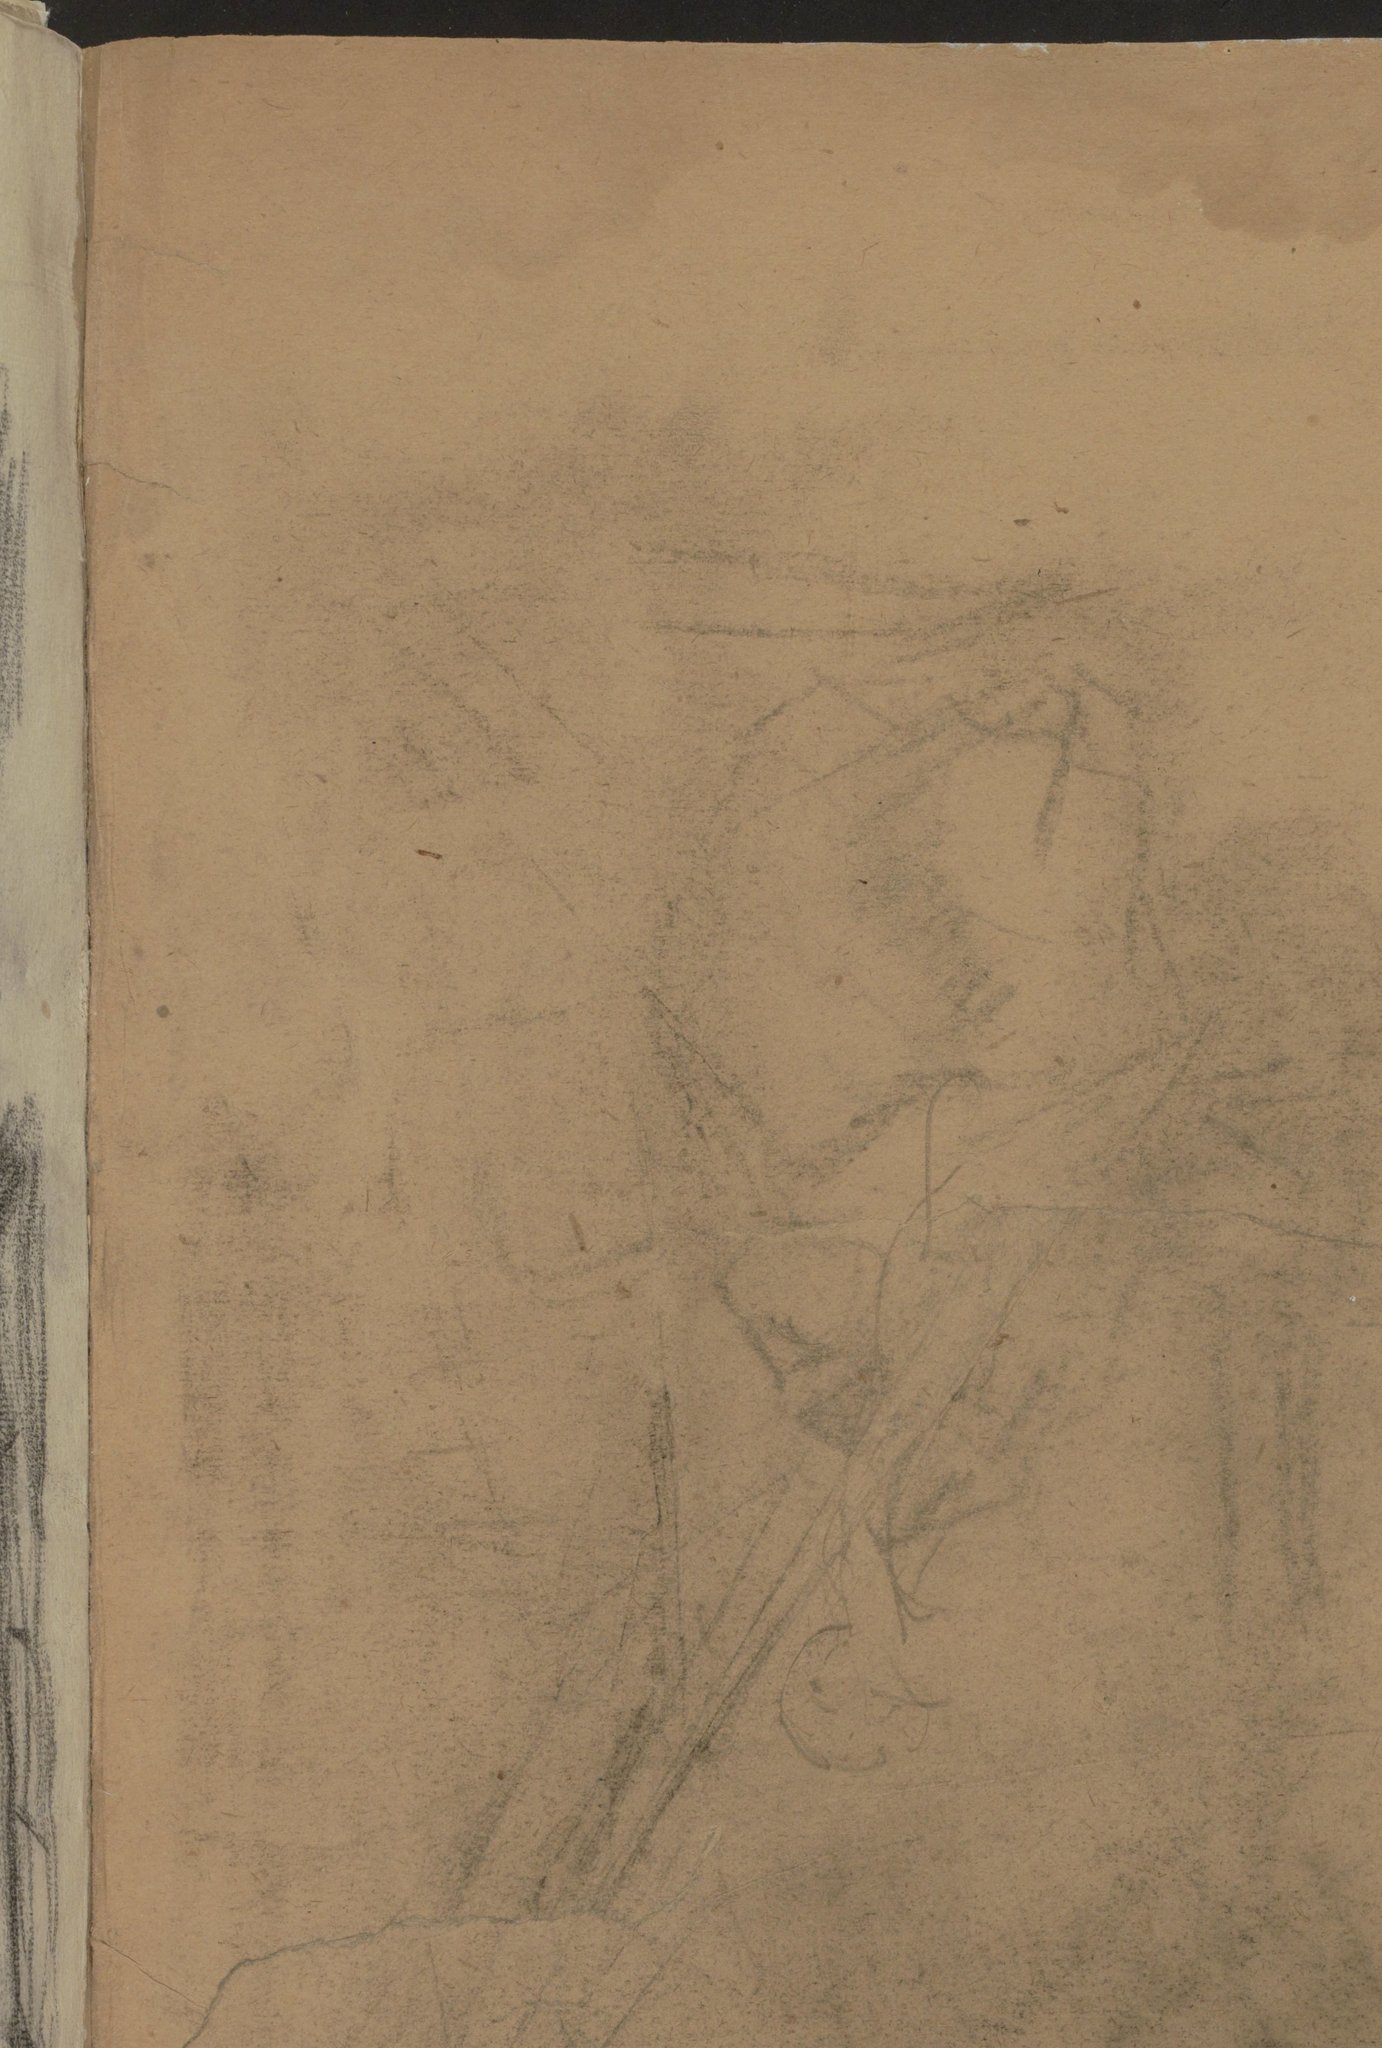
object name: sketchbook leaf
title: Studie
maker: albert neuhuys (1844-1914)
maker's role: draughtsman, painter, print maker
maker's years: 1844-1914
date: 1854-1914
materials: chalk, paper, pencil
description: Blad 50 recto uit een schetsboek met 53 bladen.